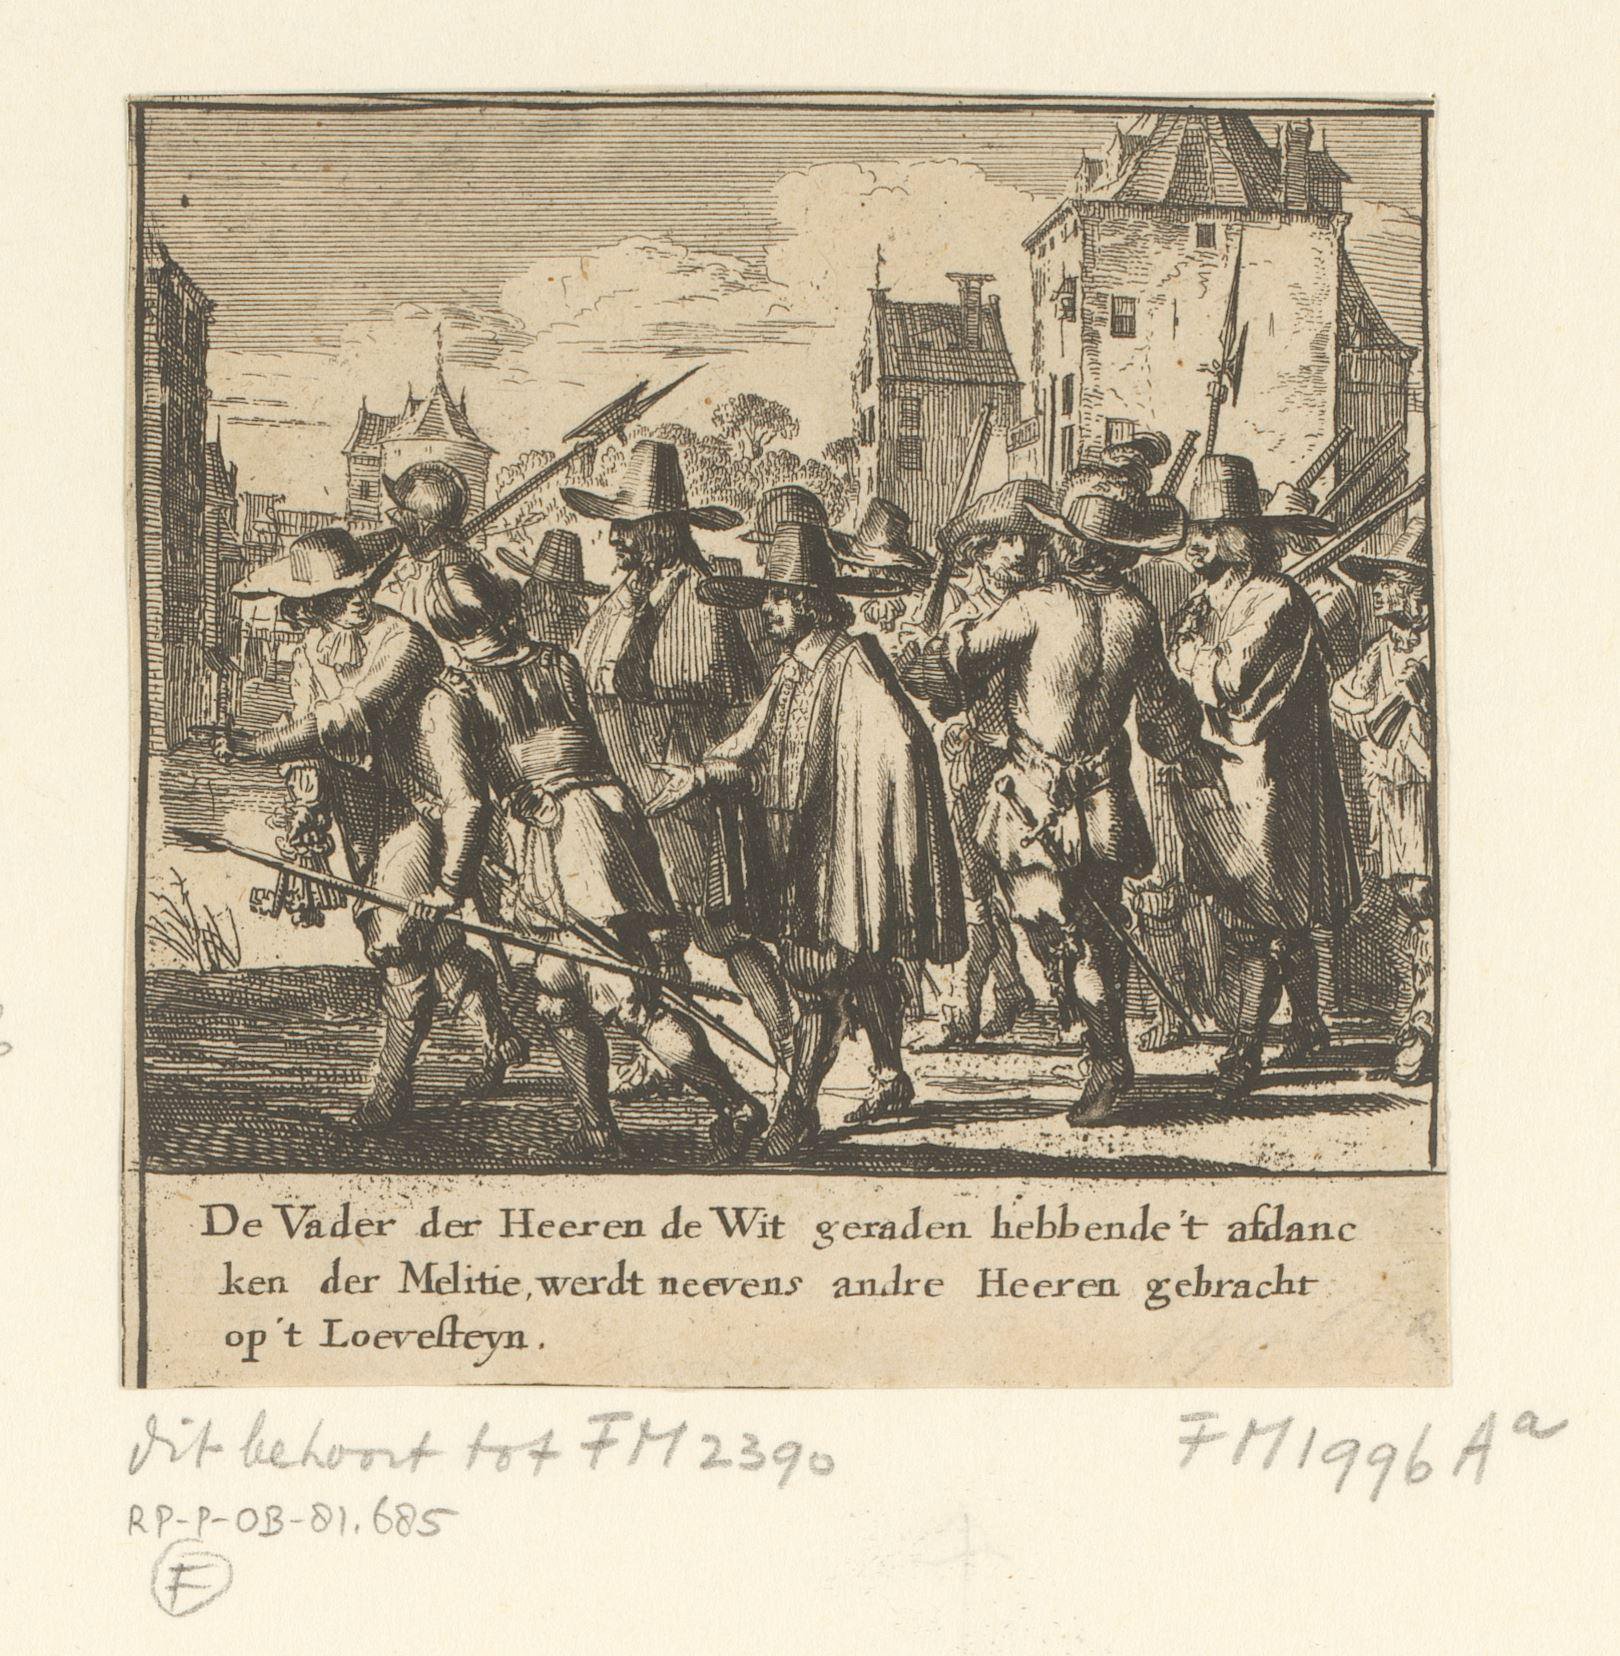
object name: print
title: Arrestatie van Jacob de Witt, 1650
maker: romeyn de hooghe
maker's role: draughtsman, goldsmith, painter, print maker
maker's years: 1645-1708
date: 1675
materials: paper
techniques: etching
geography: northern netherlands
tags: william ii (prince of orange), mayor, arrest (of criminal), amsterdam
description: Arrestatie van Jacob de Witt, lid van de Staten van Holland namens Dordrecht, te Den Haag op bevel van prins Willem II, 30 juli 1650. De gevangenen worden op straat opgepakt om naar slot Loevestein overgebracht te worden. Fragment van de grote prent over de gebroeders De Witt: Witten Wonder Spiegel (1675).